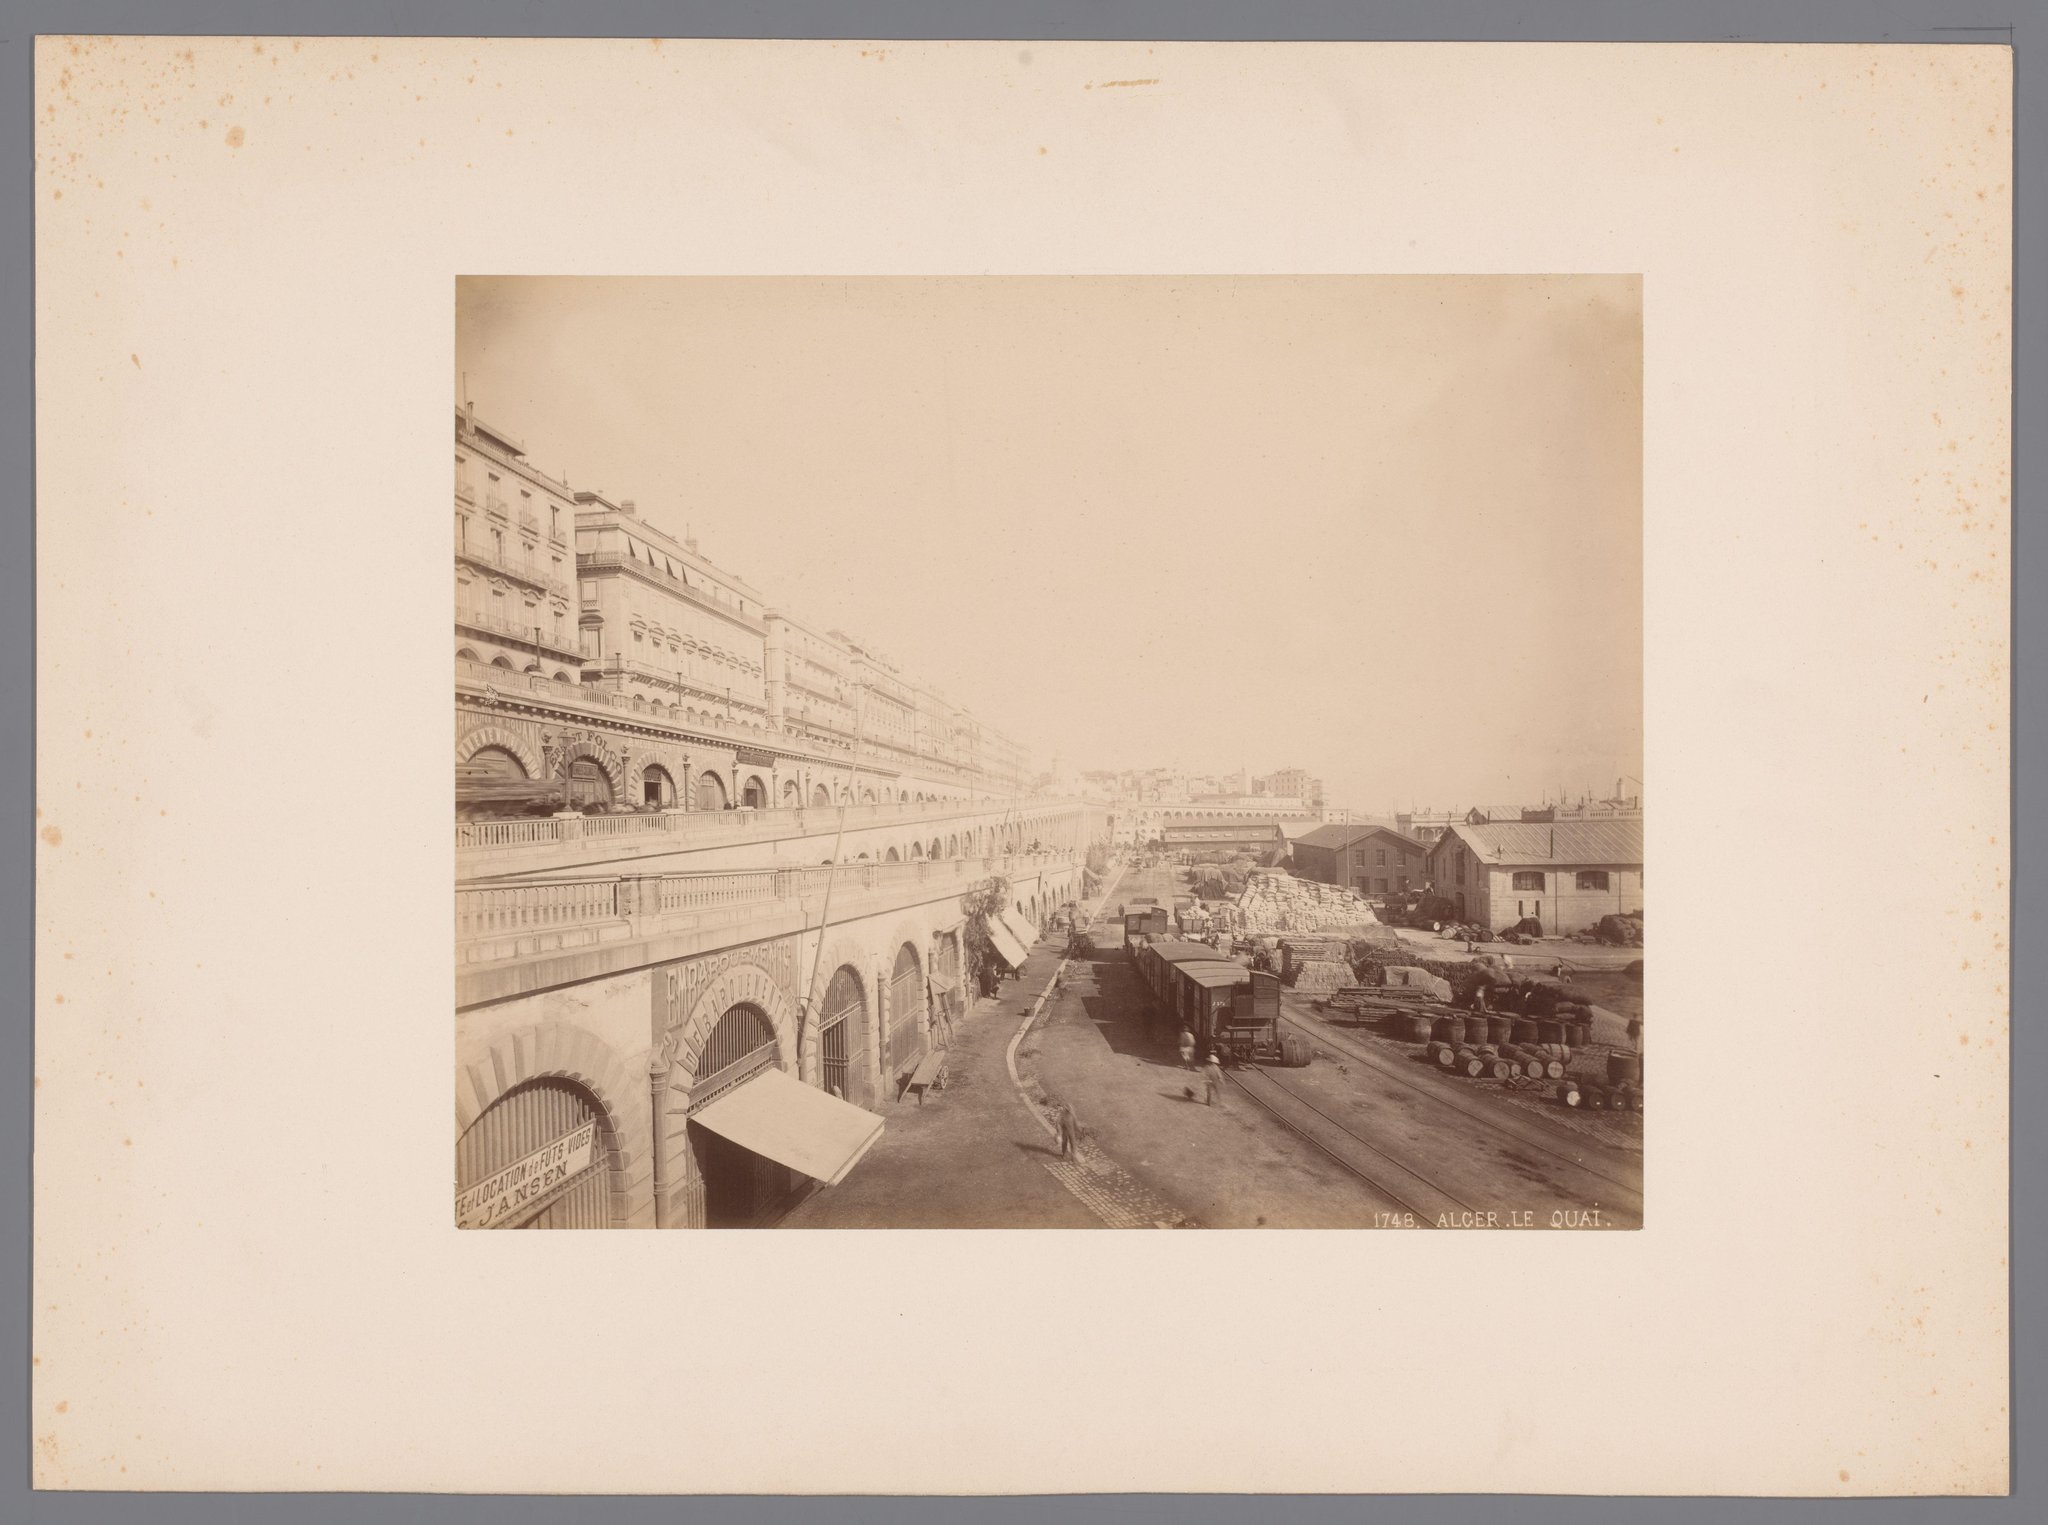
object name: photograph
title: Huidige Boulevard Ernesto Che Guevara, Algiers, Algerije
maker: Anonymous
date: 1866-1890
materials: cardboard, photographic support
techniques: albumen print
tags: algiers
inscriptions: inscription: ‘1748. ALGER LE QUAI.’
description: Aanzicht op de boulevard en de goederenoverslag daar beneden.